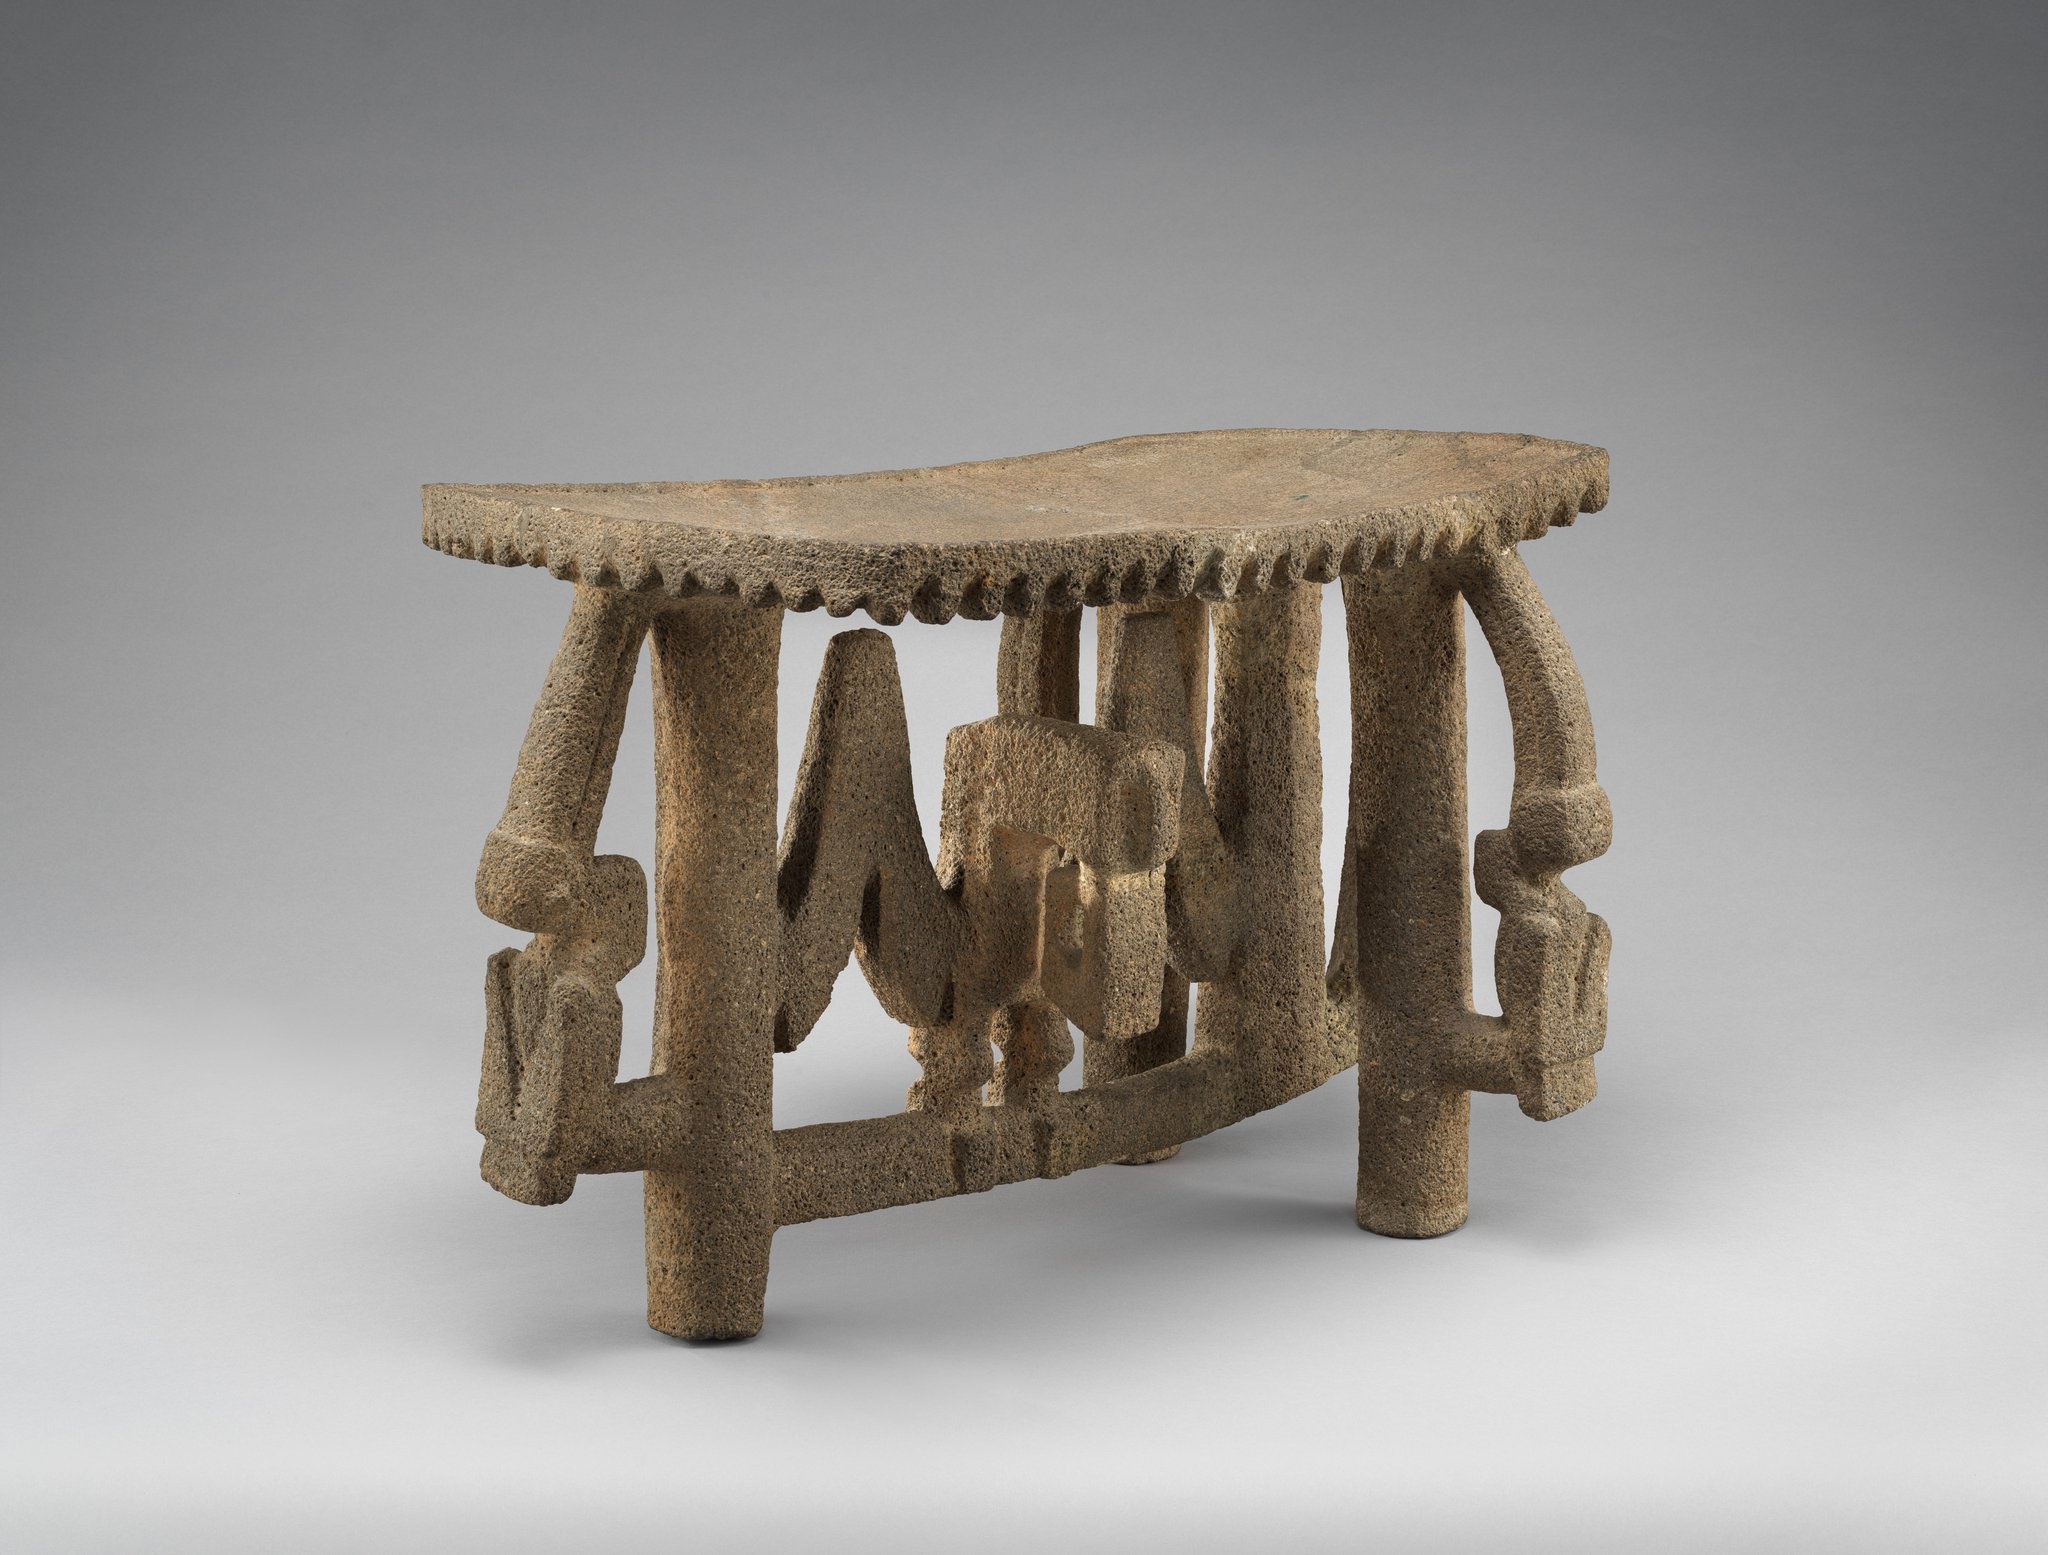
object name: metate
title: Flying Panel Metate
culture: central region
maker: central region artist(s)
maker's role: artist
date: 1-500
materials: stone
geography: costa rica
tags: birds